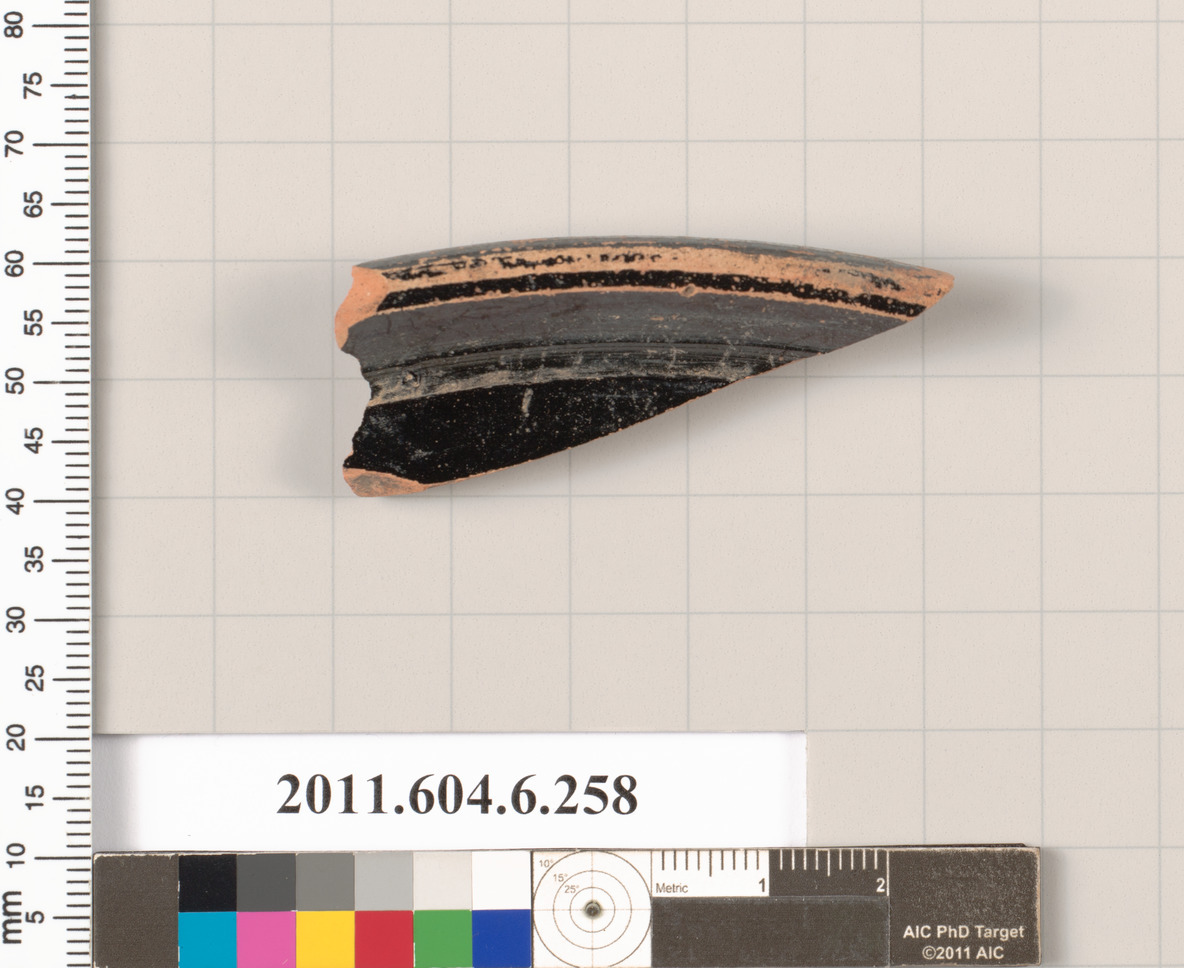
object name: plate fragment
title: Terracotta fragment of a plate?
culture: greek, attic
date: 500-401 BCE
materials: terracotta